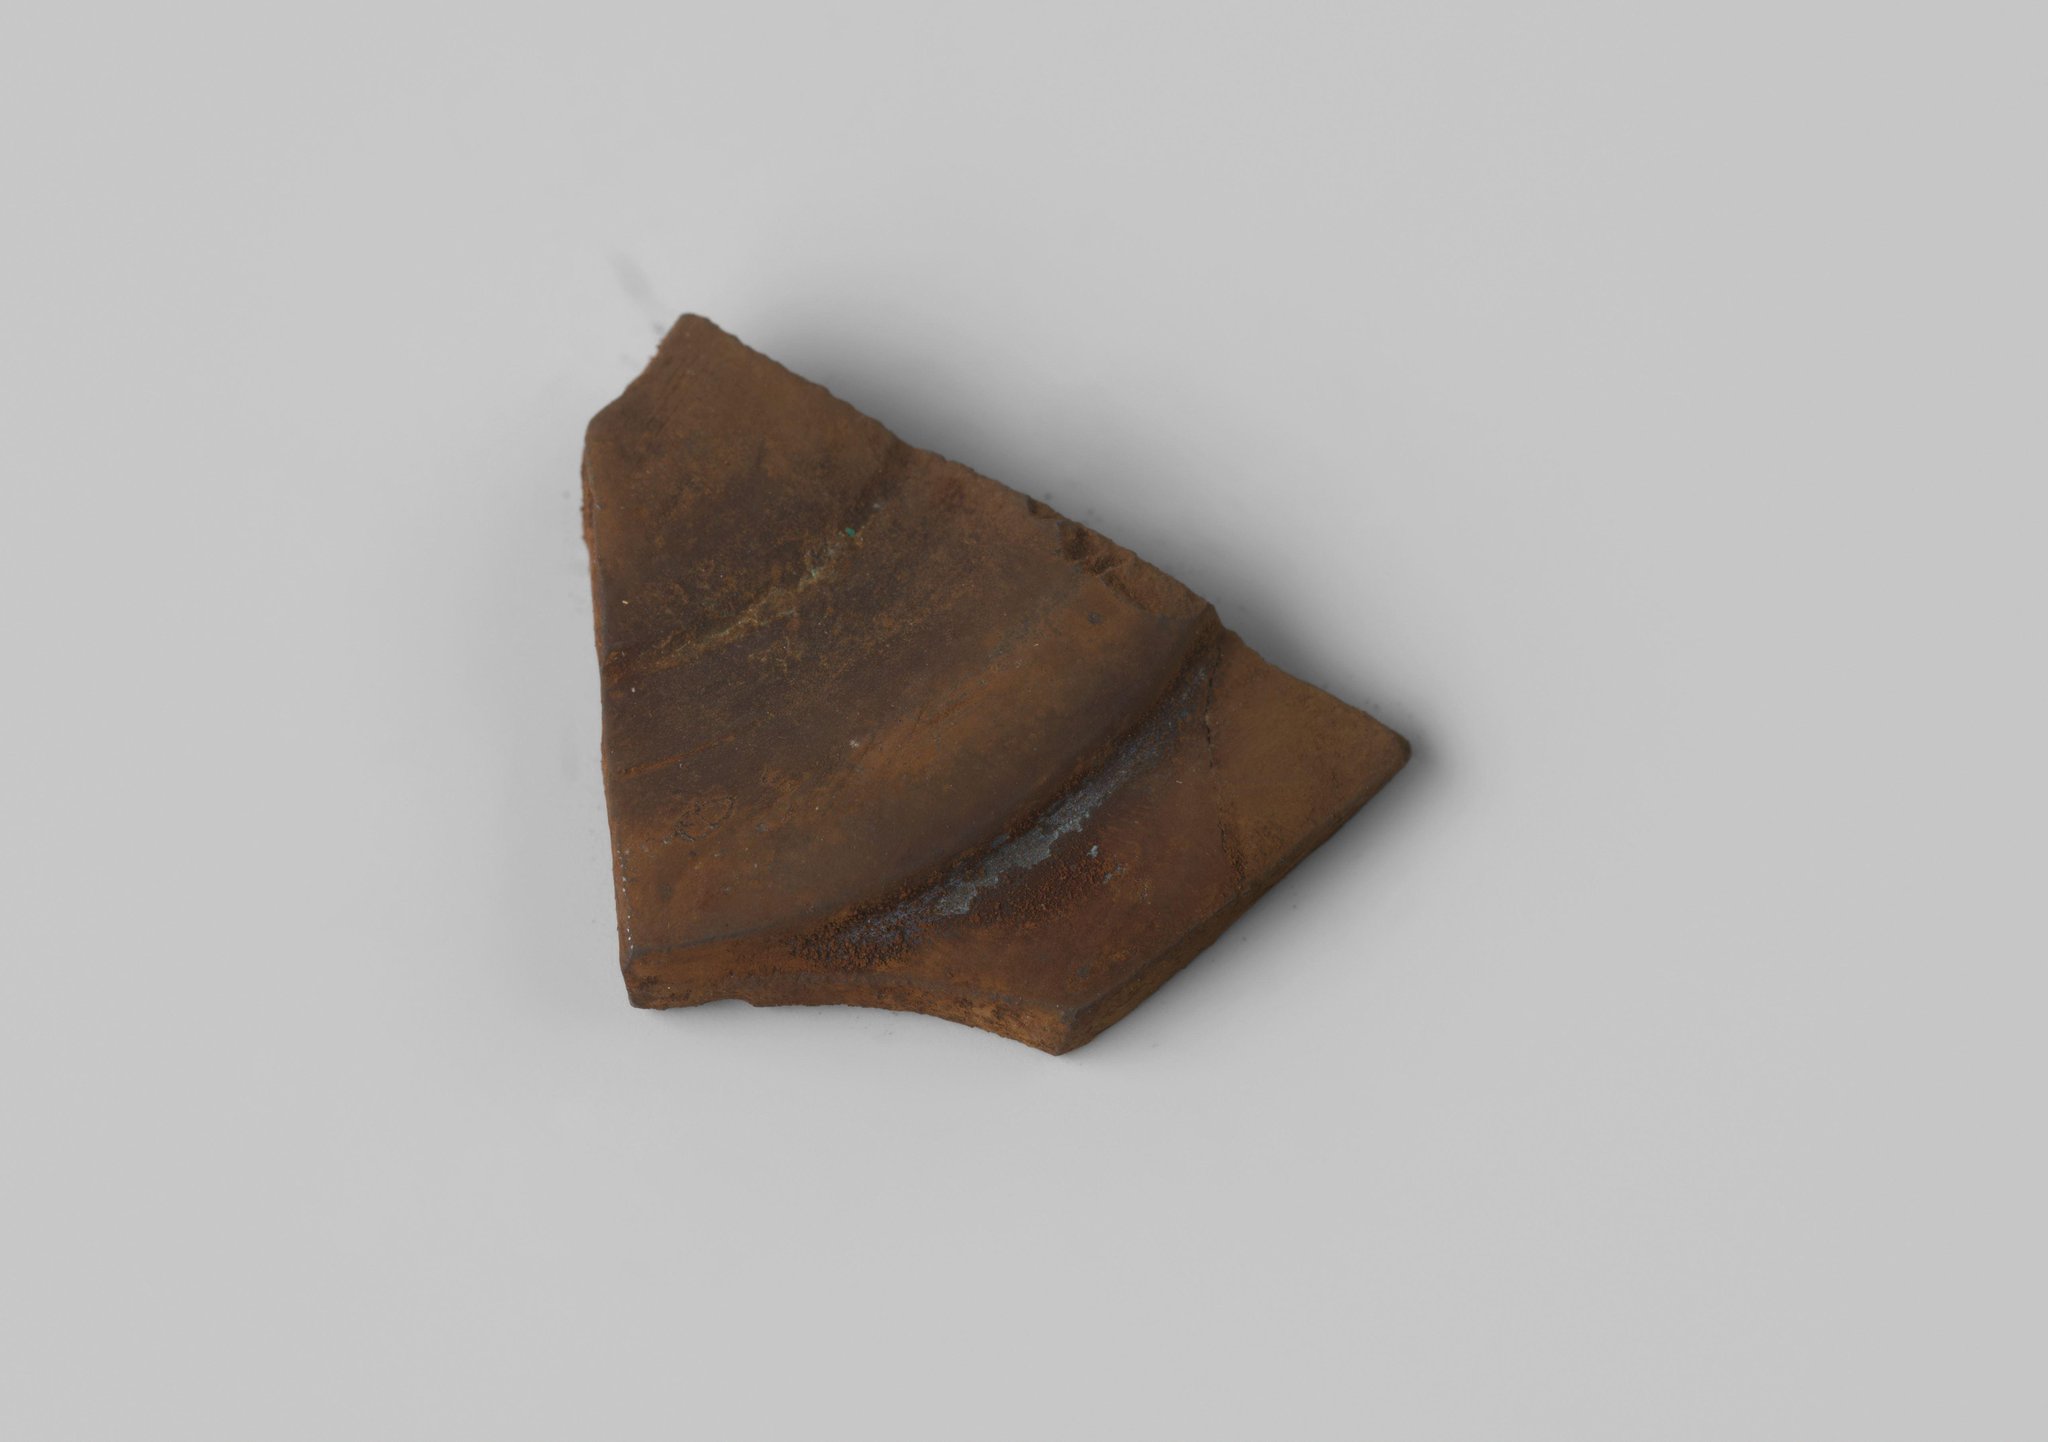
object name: base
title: Fragment van een voetstuk van een verpakking uit het wrak van de Oost-Indiëvaarder Hollandia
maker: Anonymous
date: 1700-1743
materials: iron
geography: netherlands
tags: verenigde oostindische compagnie, hollandia (schip), annet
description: Container, fragment: base; fragm, circular outline, moulded.